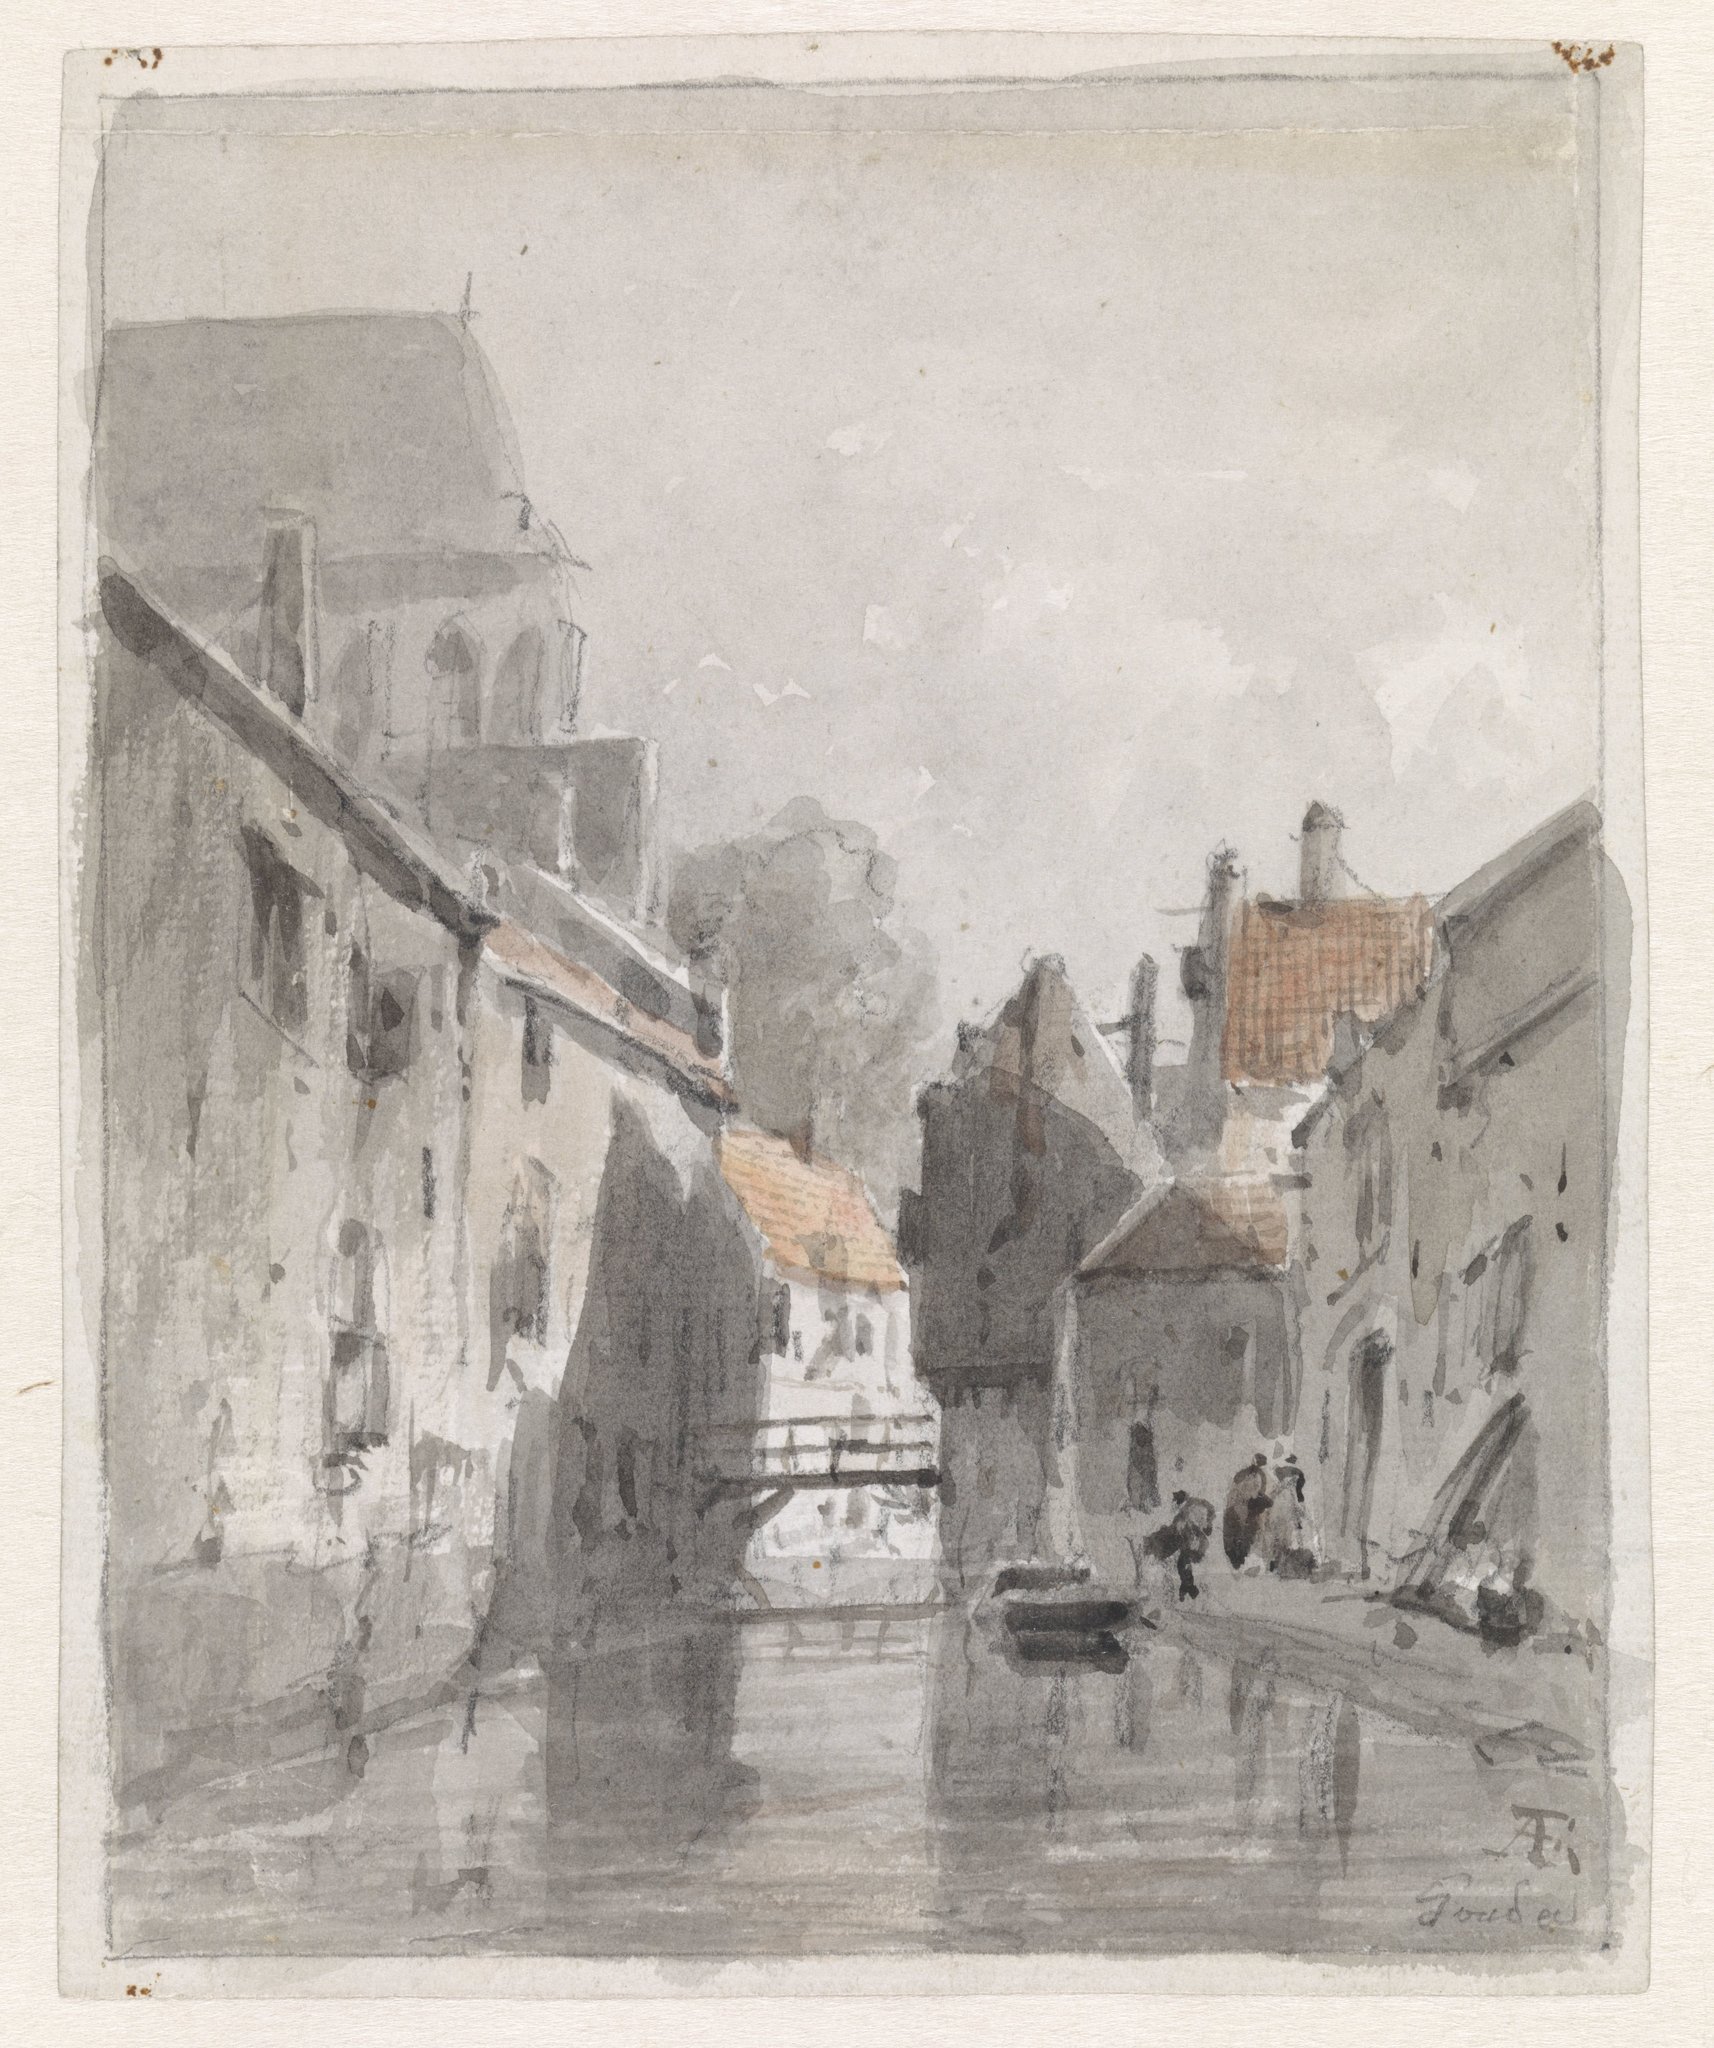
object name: drawing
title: Gezicht op een grachtje in Gouda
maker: adrianus eversen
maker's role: draughtsman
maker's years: 1818-1897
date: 1828-1897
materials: paper, pencil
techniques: brush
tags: gouda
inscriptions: monogram: ‘AE’, annotation: ‘Gouda’